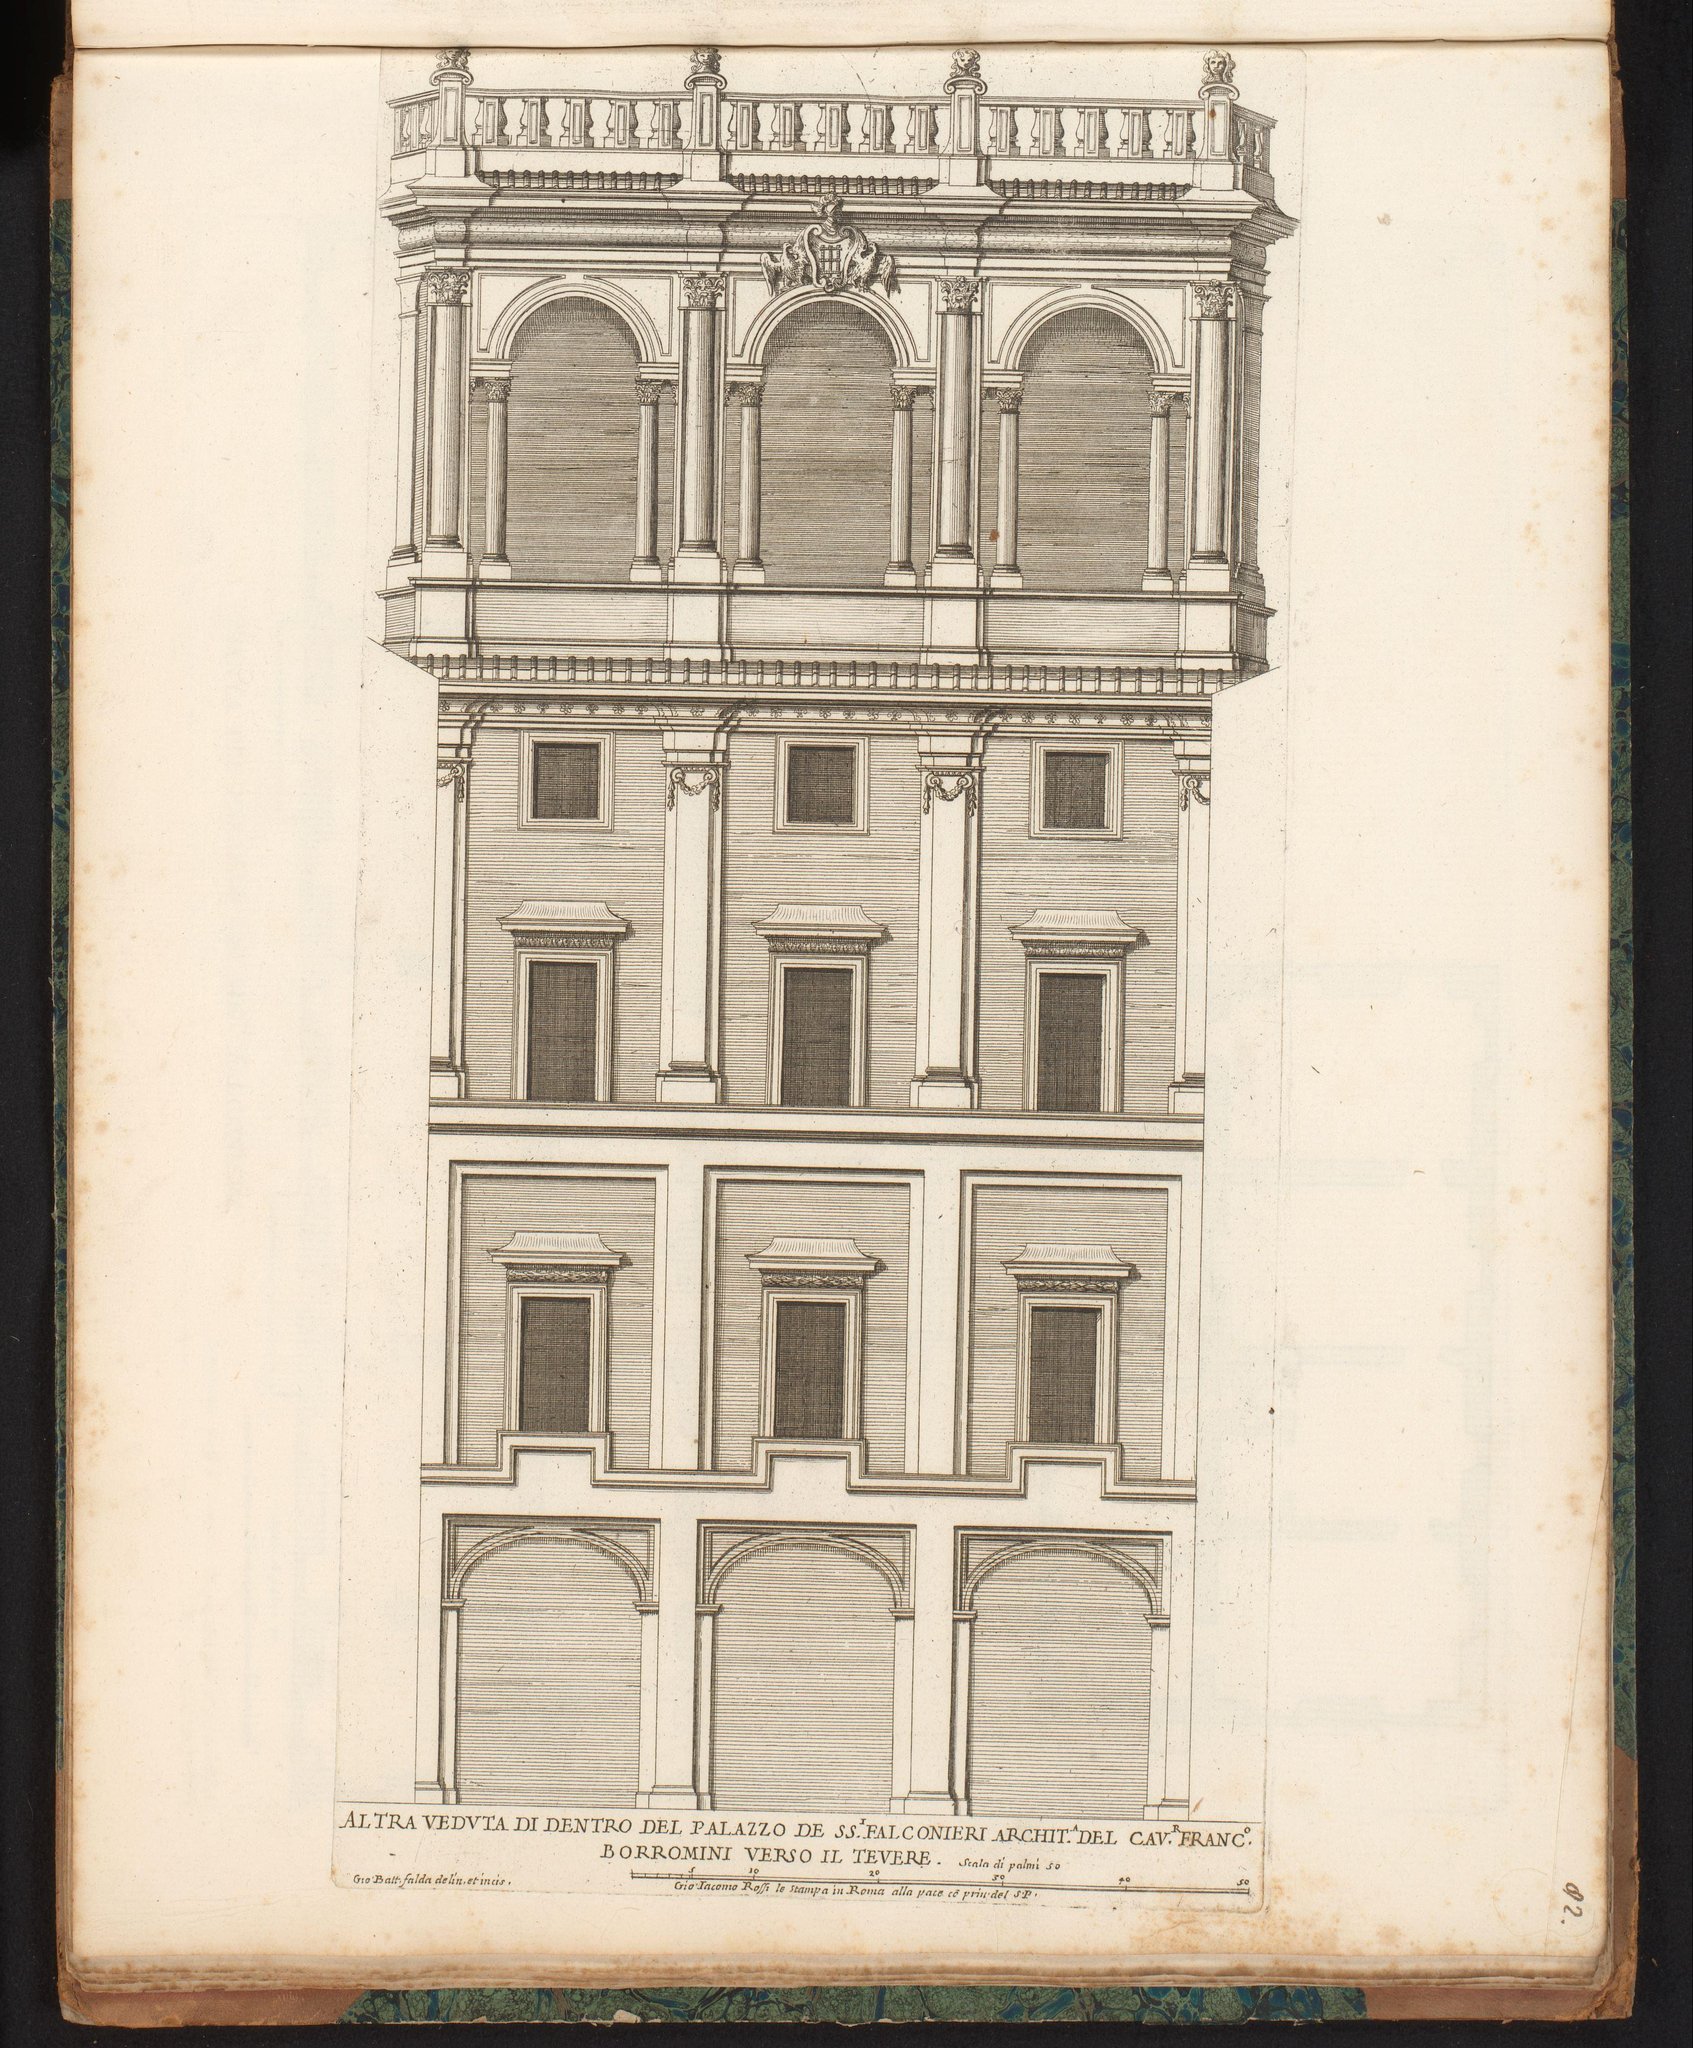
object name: print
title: Romeinse paleizen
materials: paper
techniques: etching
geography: italy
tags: palace, façade (of house or building), inner court of palace or 'hôtel'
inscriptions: number: ‘82’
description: Deze prent maakt deel uit van de reeks getiteld: Palazzi di Roma. Deze reeks bestaat uit twee boeken. Boek één getiteld: Palazzi di Roma dei più celebri architetti..., bestaat uit 44 prenten die worden toegeschreven aan Giovanni Battista Falda (naam staat enkel op prent 27) en uitgegeven door Giovanni Giacomo de'Rossi. Deze 44 prenten zijn bekend in twee staten (met en zonder nummer). Boek twee getiteld: Nuovi disegni dell'architetture... libro secondo, bevat 66 prenten door Giovanni Battista Falda en Simone Felice. Deze 66 prenten zijn bekend in twee staten (met en zonder nummer).